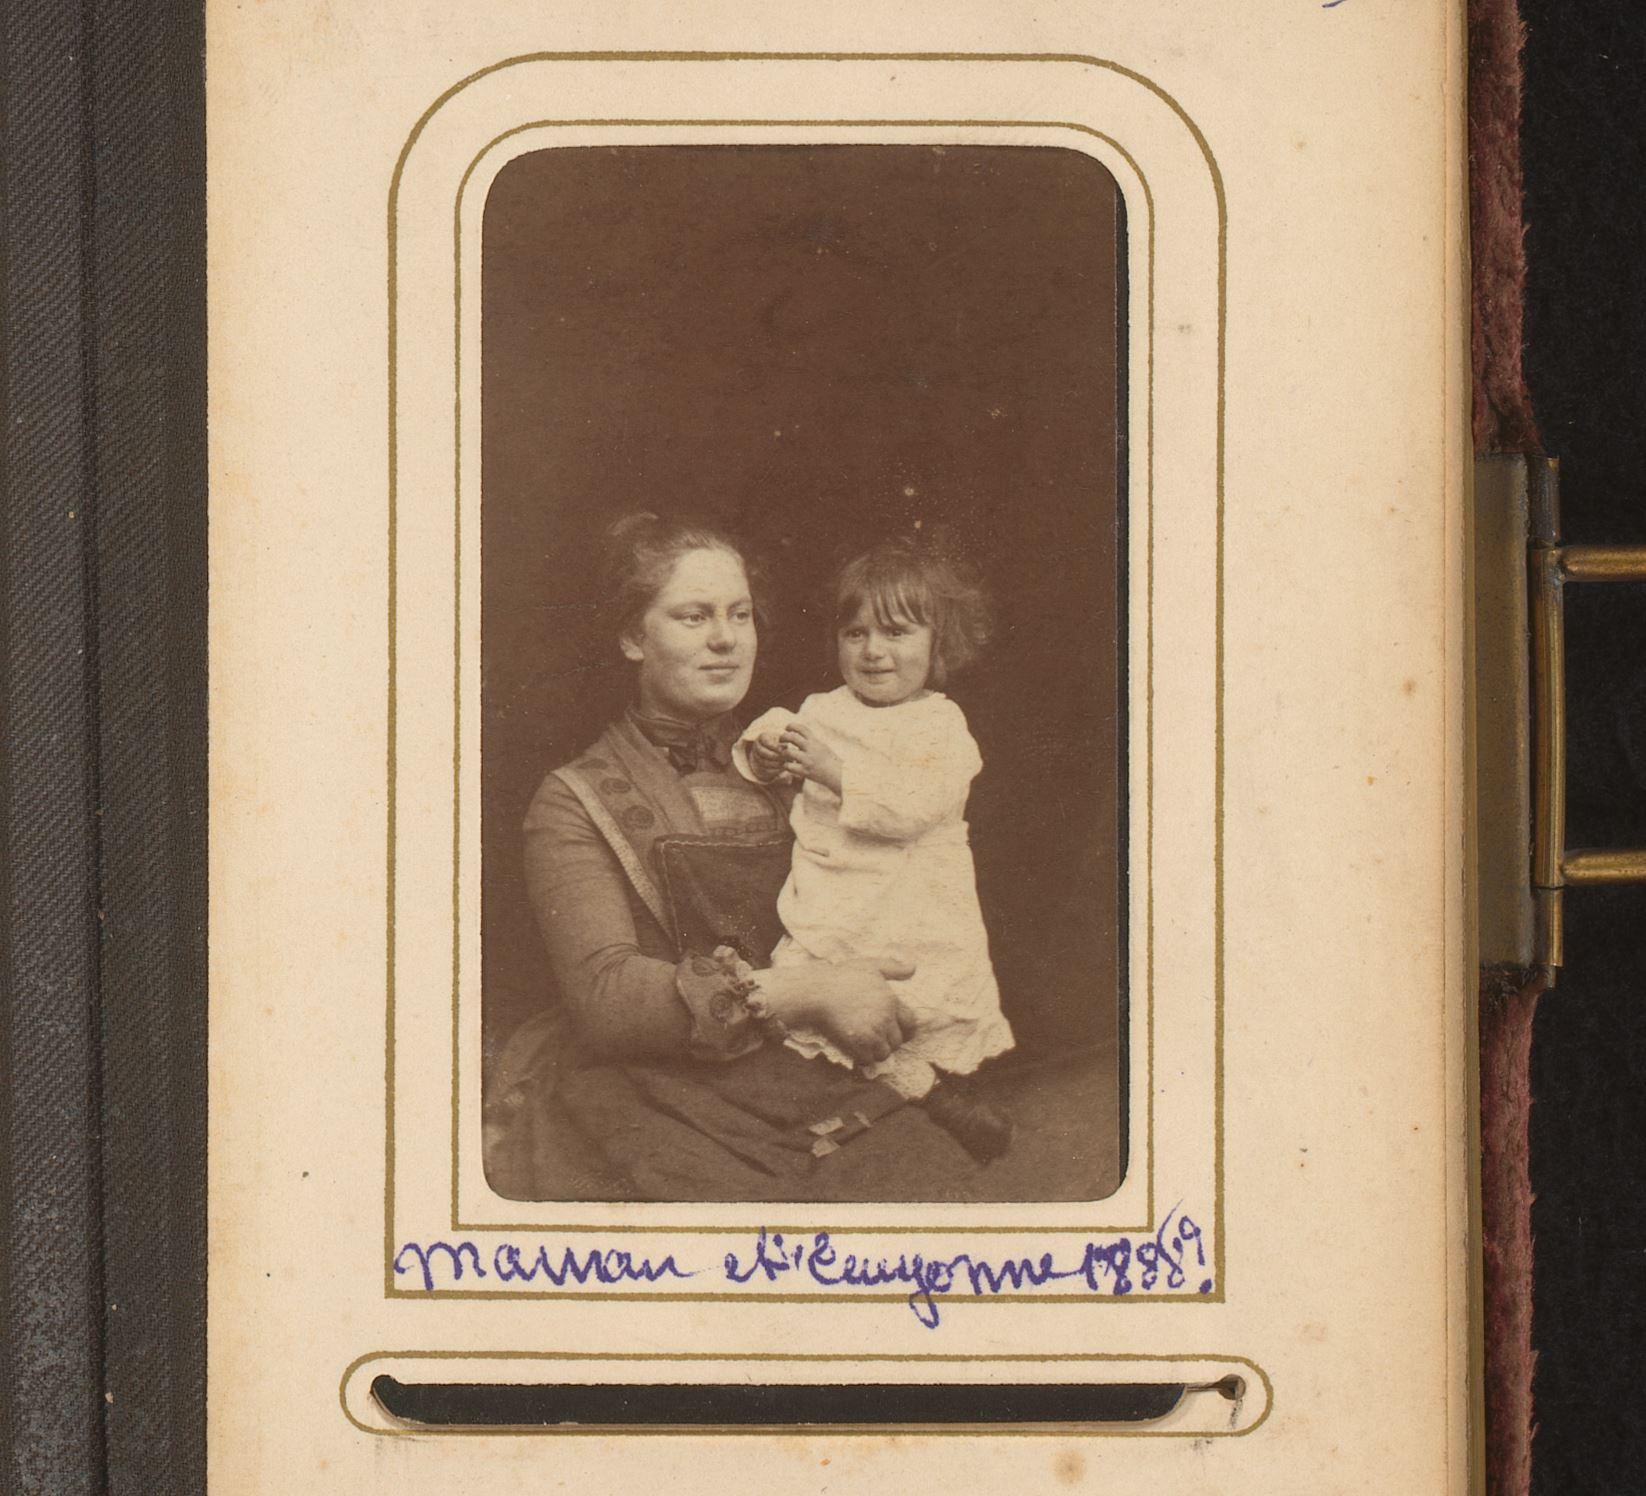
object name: photograph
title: Portret van een vrouw met kind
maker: Anonymous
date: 1860-1900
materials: cardboard, photographic support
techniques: albumen print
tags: adult woman, child, historical persons, mother and child(ren), woman and child(ren) (family group)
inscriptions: annotation: ‘Maman et Eugenne 1888?’